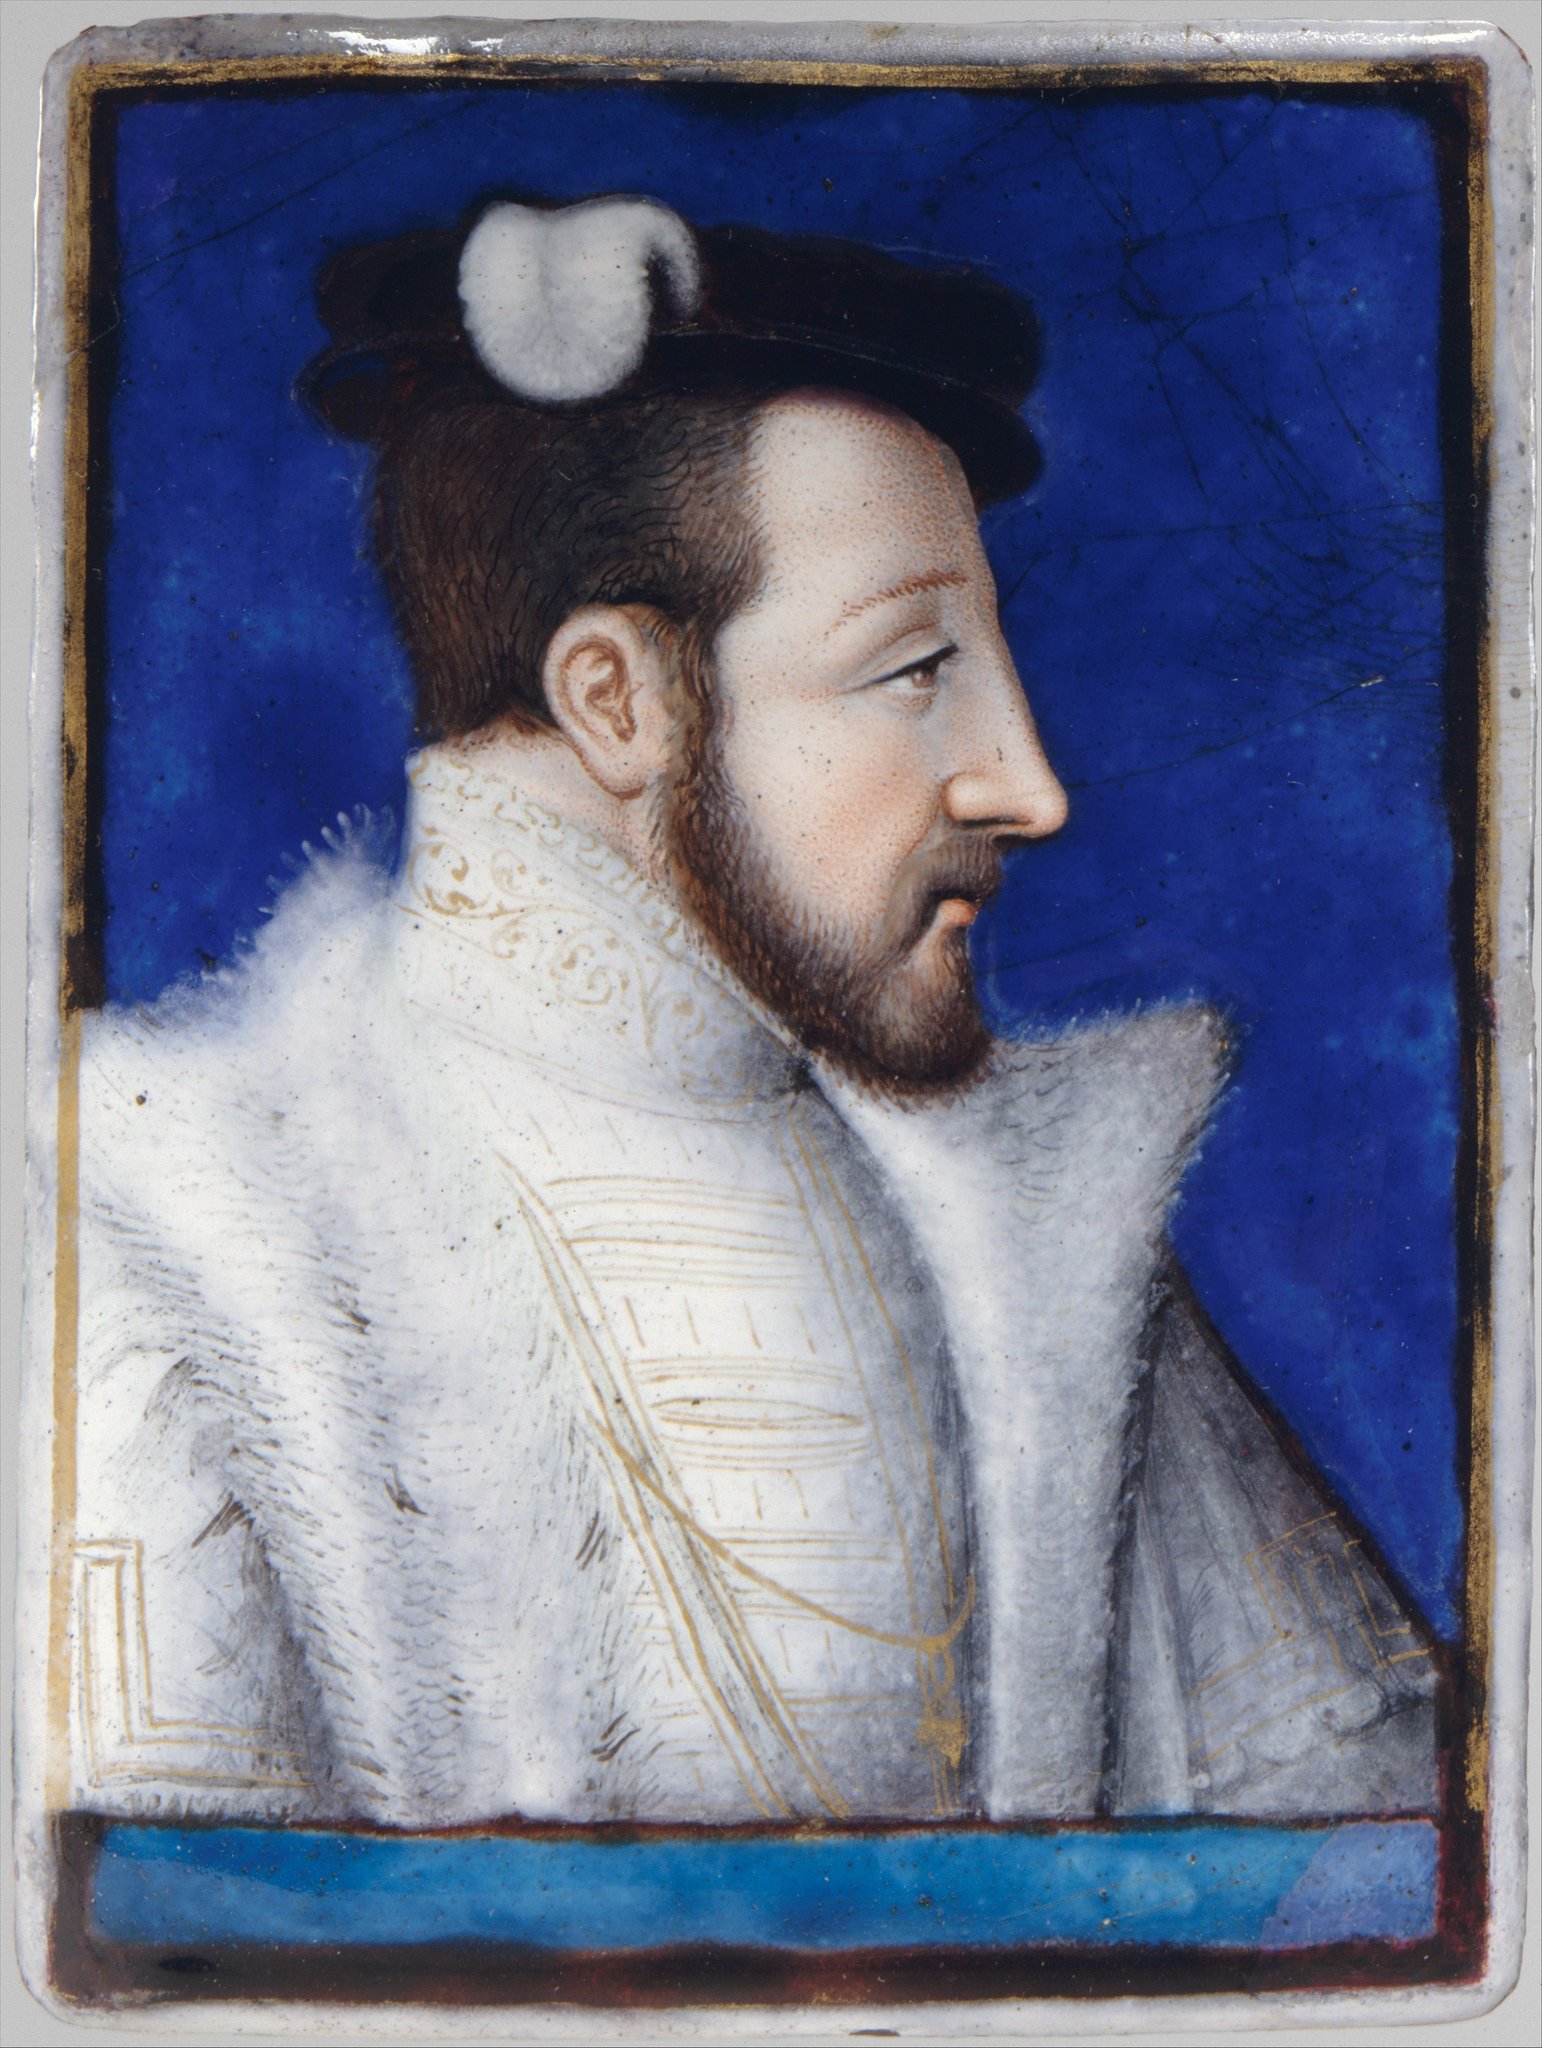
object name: plaque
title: Henri II, King of France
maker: léonard limosin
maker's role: enameler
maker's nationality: french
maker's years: 1505-1577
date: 1555-1560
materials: copper, enamel, gilt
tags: kings,men,profiles